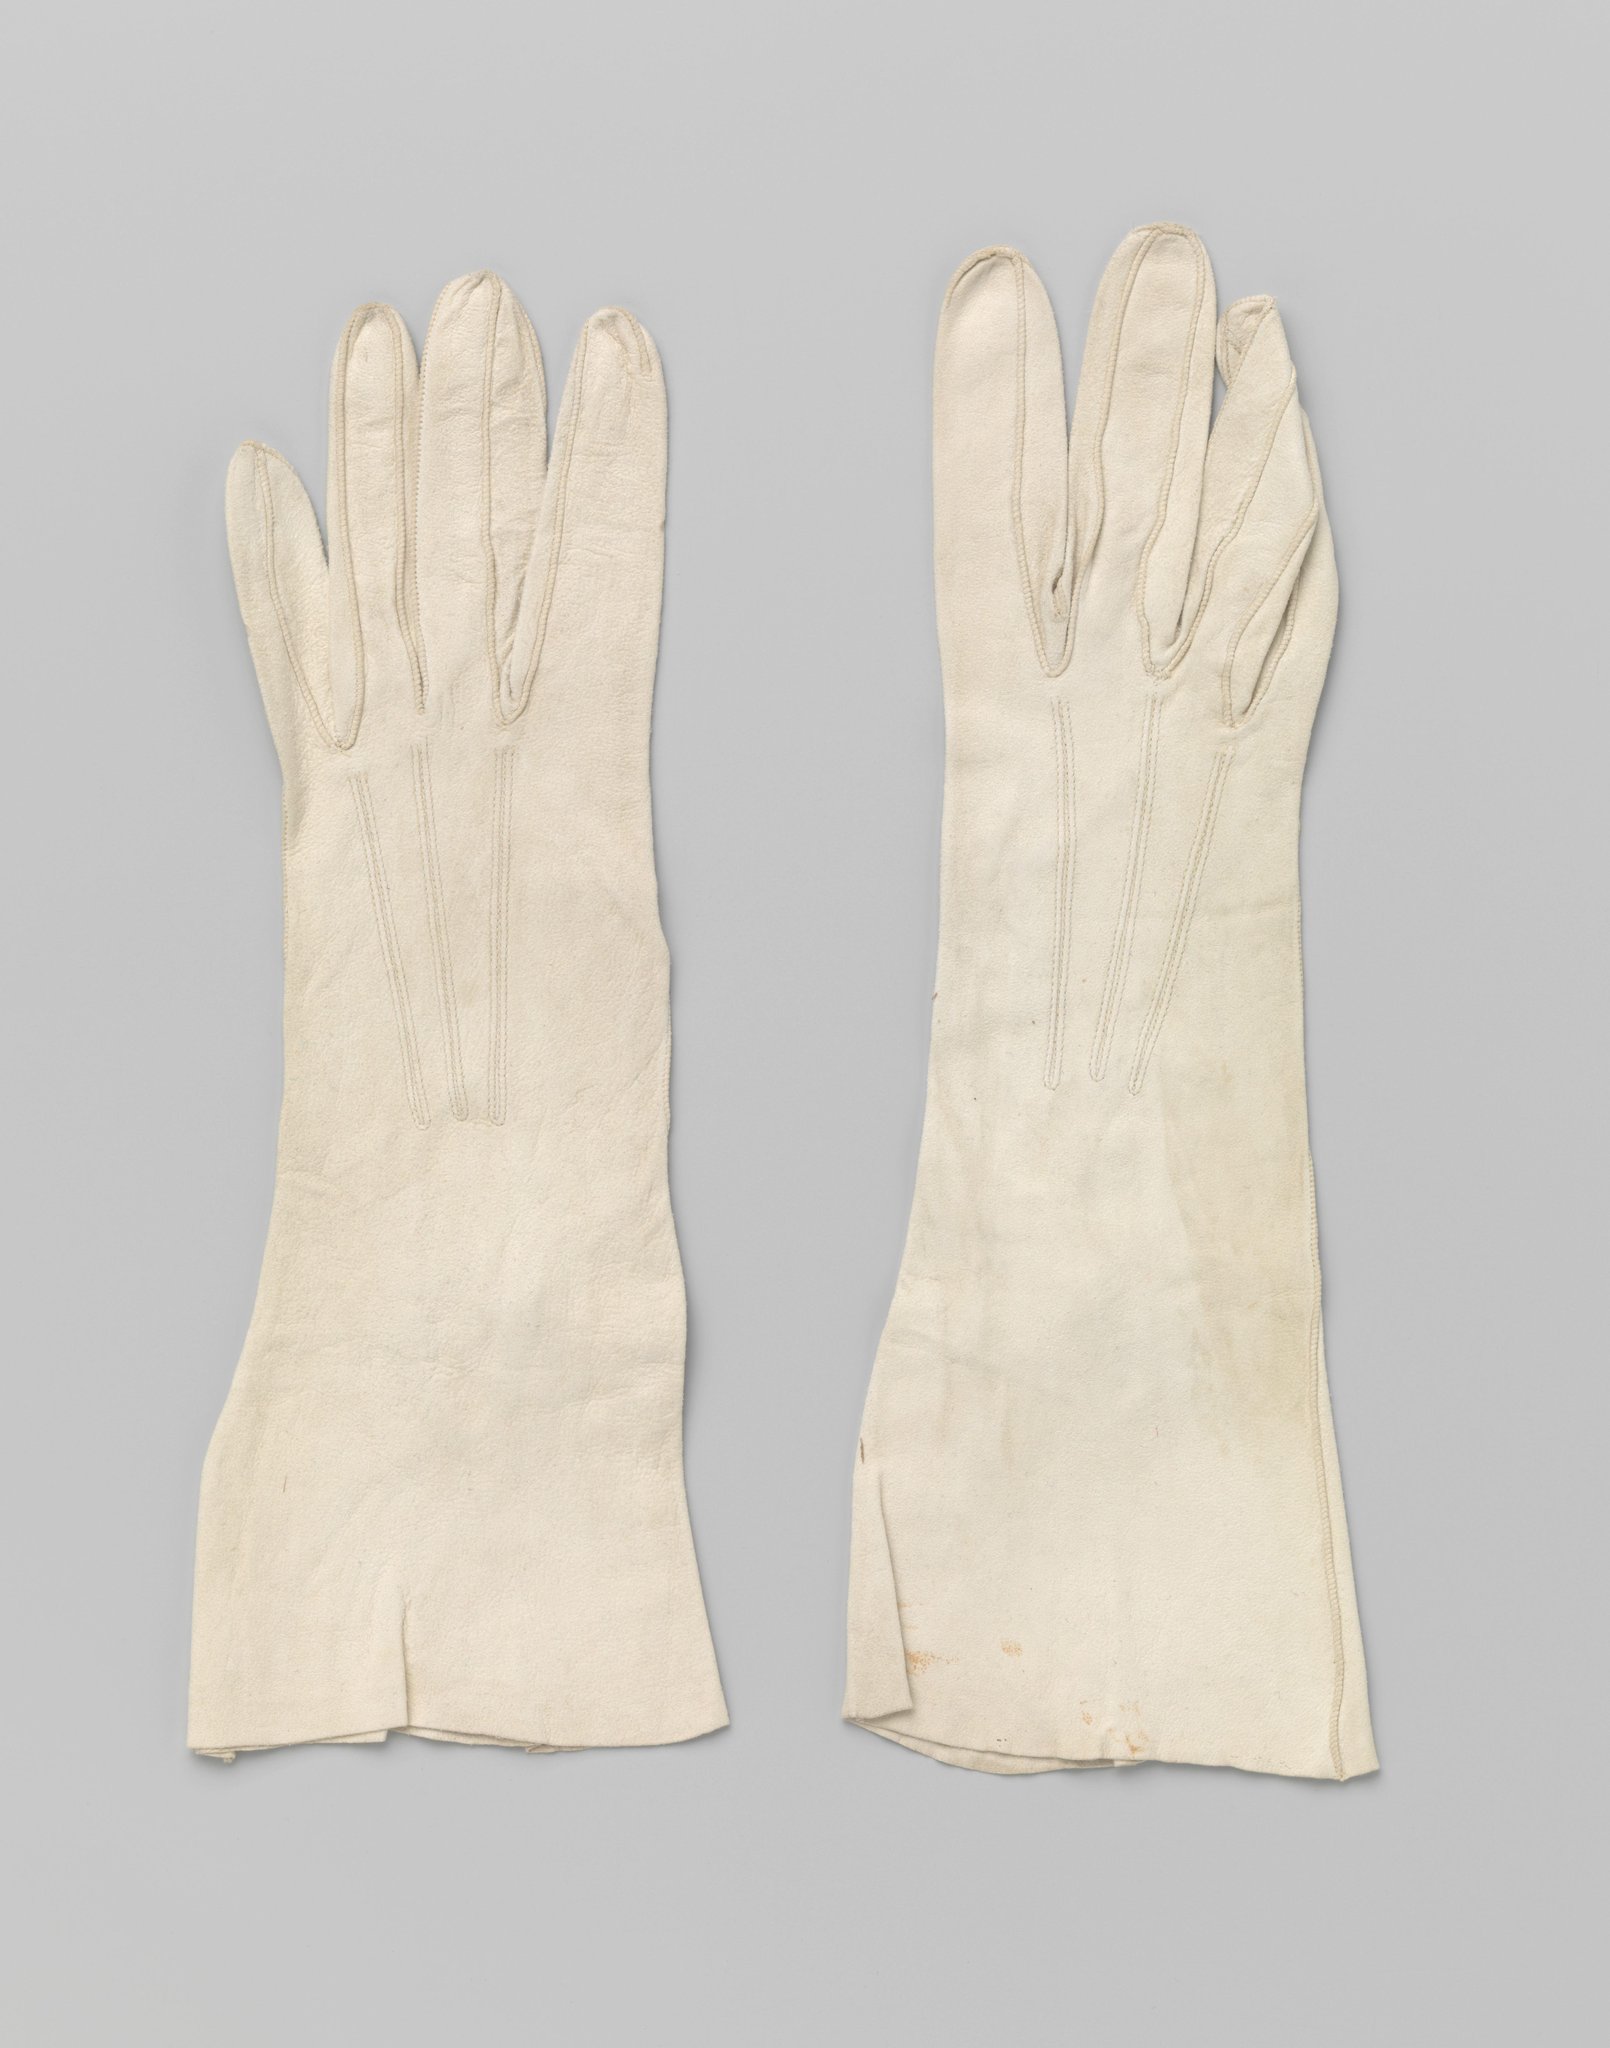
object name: clothing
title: Handschoen van wit zeemleer met kunsstof parelmoerkleurige knoop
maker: Anonymous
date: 1900-1915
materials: leather, plastic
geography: western europe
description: linker handschoen van wit zeemleer met kunsstof parelmoerkleurige knoop.